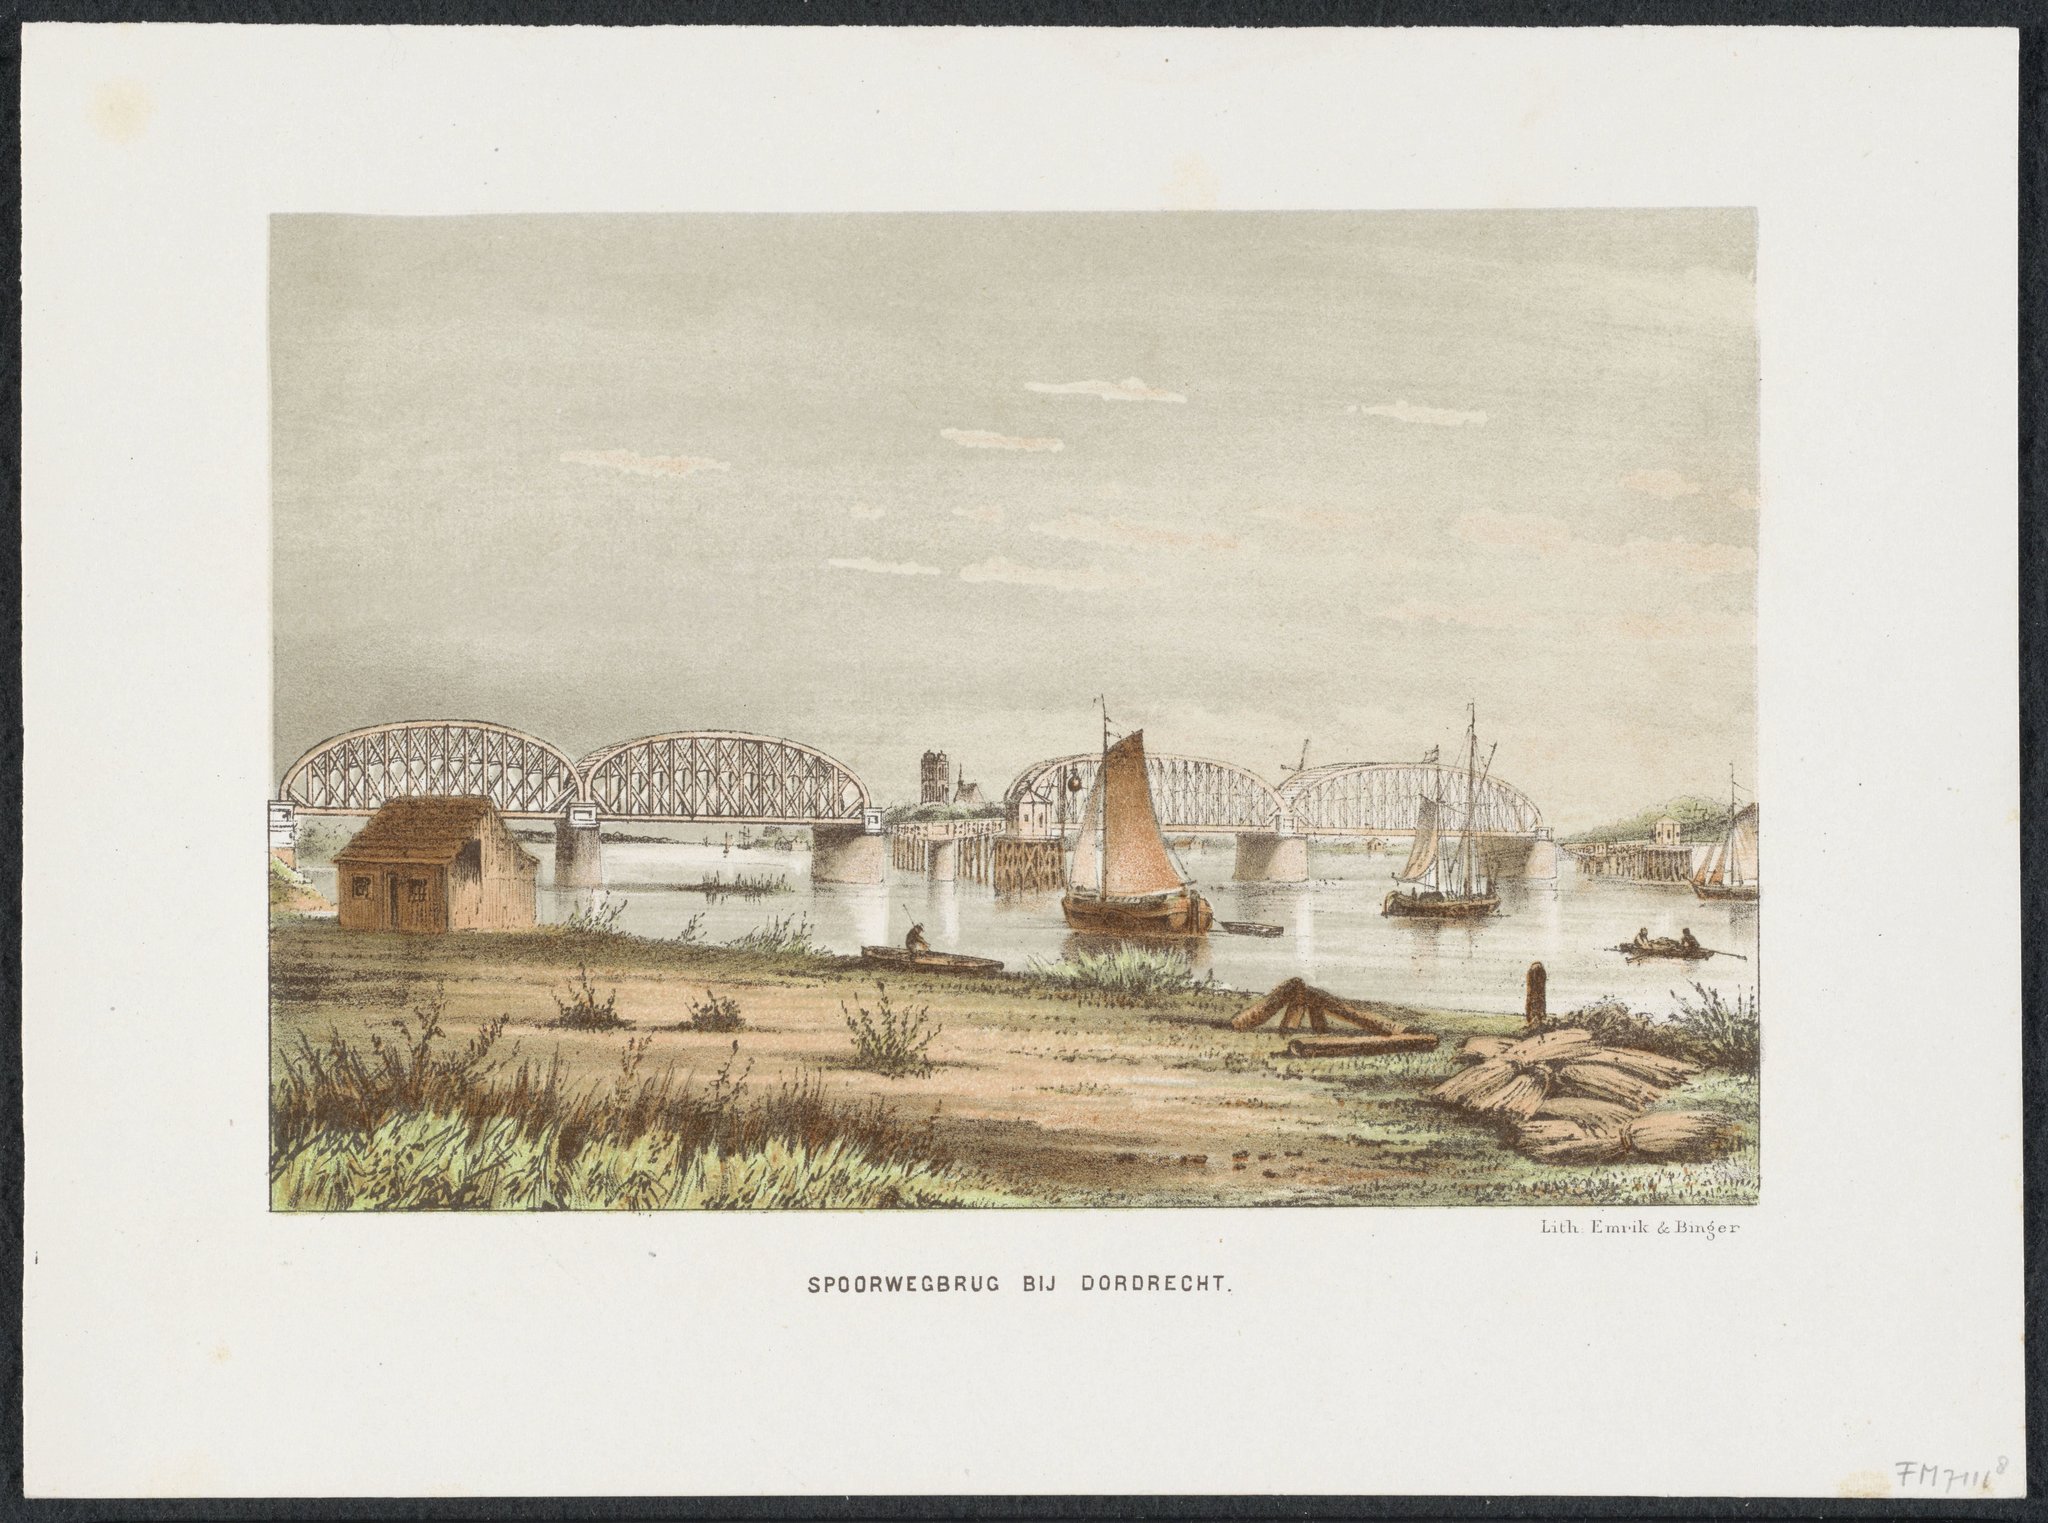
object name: print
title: Spoorbrug bij Dordrecht, 1872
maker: Anonymous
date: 1872-1874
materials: paper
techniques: chromolithography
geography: netherlands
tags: railway, train, bridge, steam locomotive, dordrecht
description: De spoorbrug over de Oude Maas bij Dordrecht, in gebruik genomen in 1872. Plaat in een boekje uit 1874 met acht platen van spoorbruggen gebouwd in Nederland uit de jaren 1846-1874.